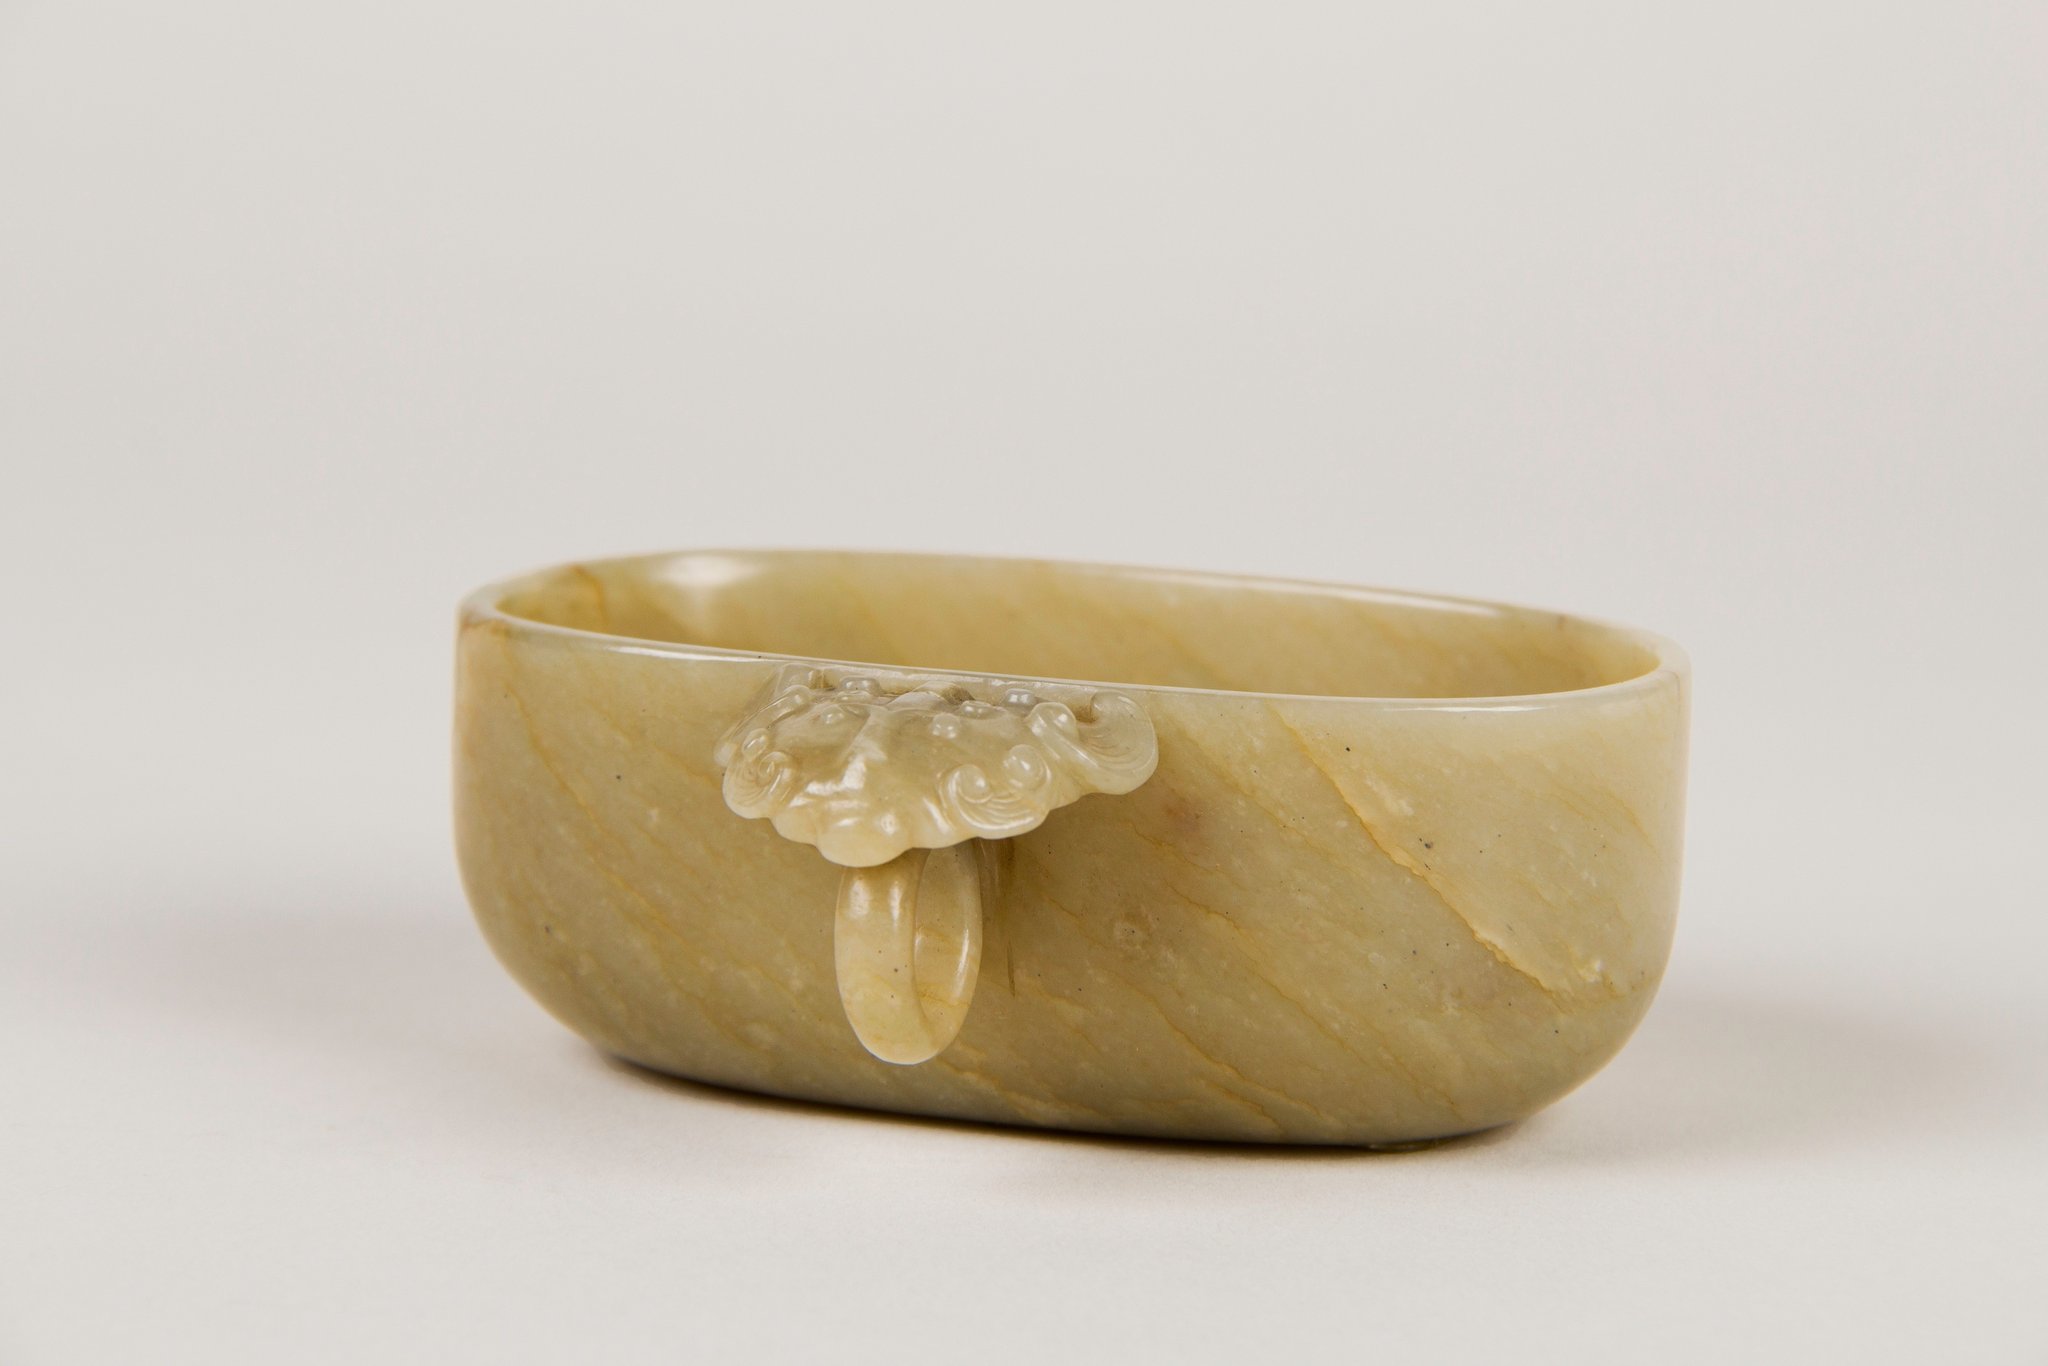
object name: wine cup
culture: chinese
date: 1902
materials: jade